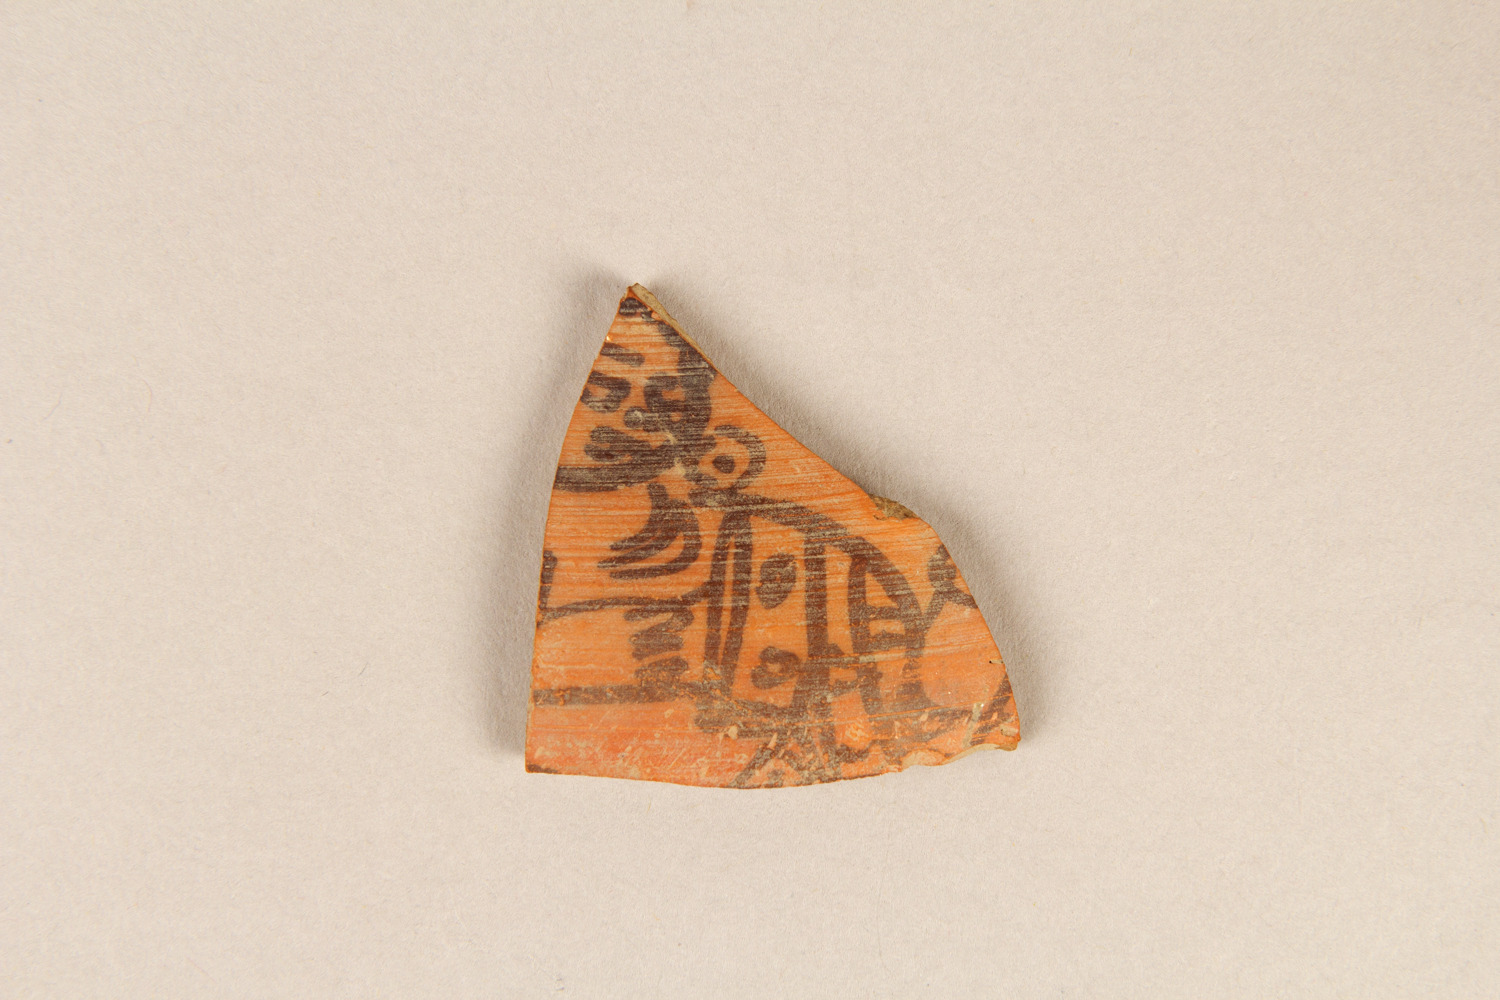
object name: shard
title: Shard with Figural and Animal Decoration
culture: pakistani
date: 301-500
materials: terracotta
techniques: painting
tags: gandhara